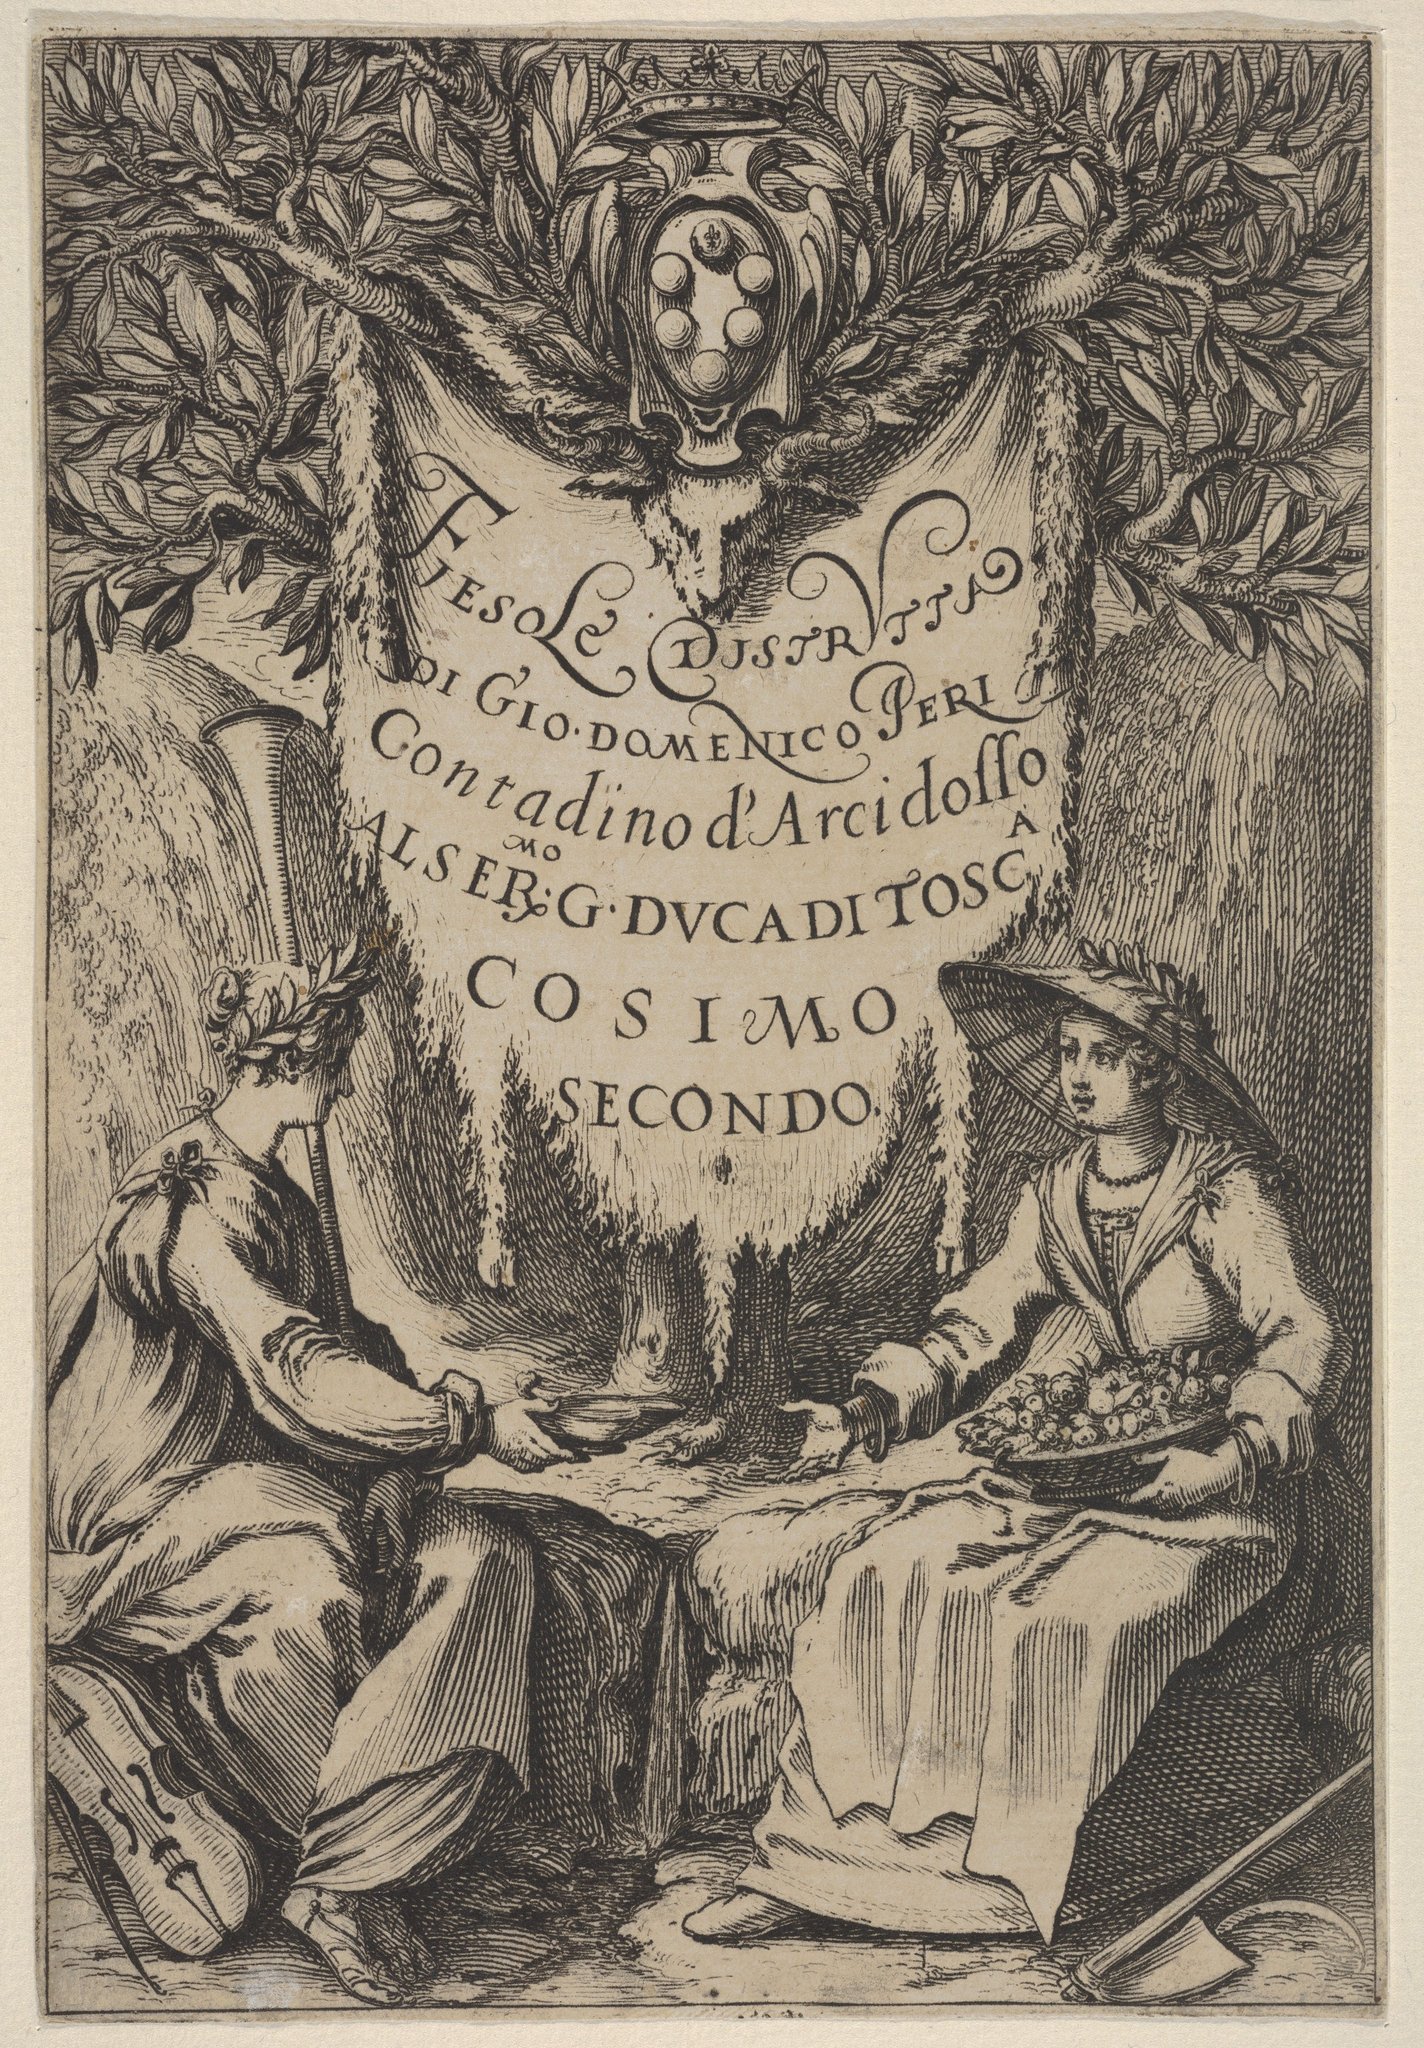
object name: print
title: Frontispiece from "Fiesole Destroyed" (Fiesole Distrutta)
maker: jacques callot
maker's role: artist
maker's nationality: french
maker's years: 1592-1635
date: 1619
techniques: etching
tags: musical instruments,women,coat of arms